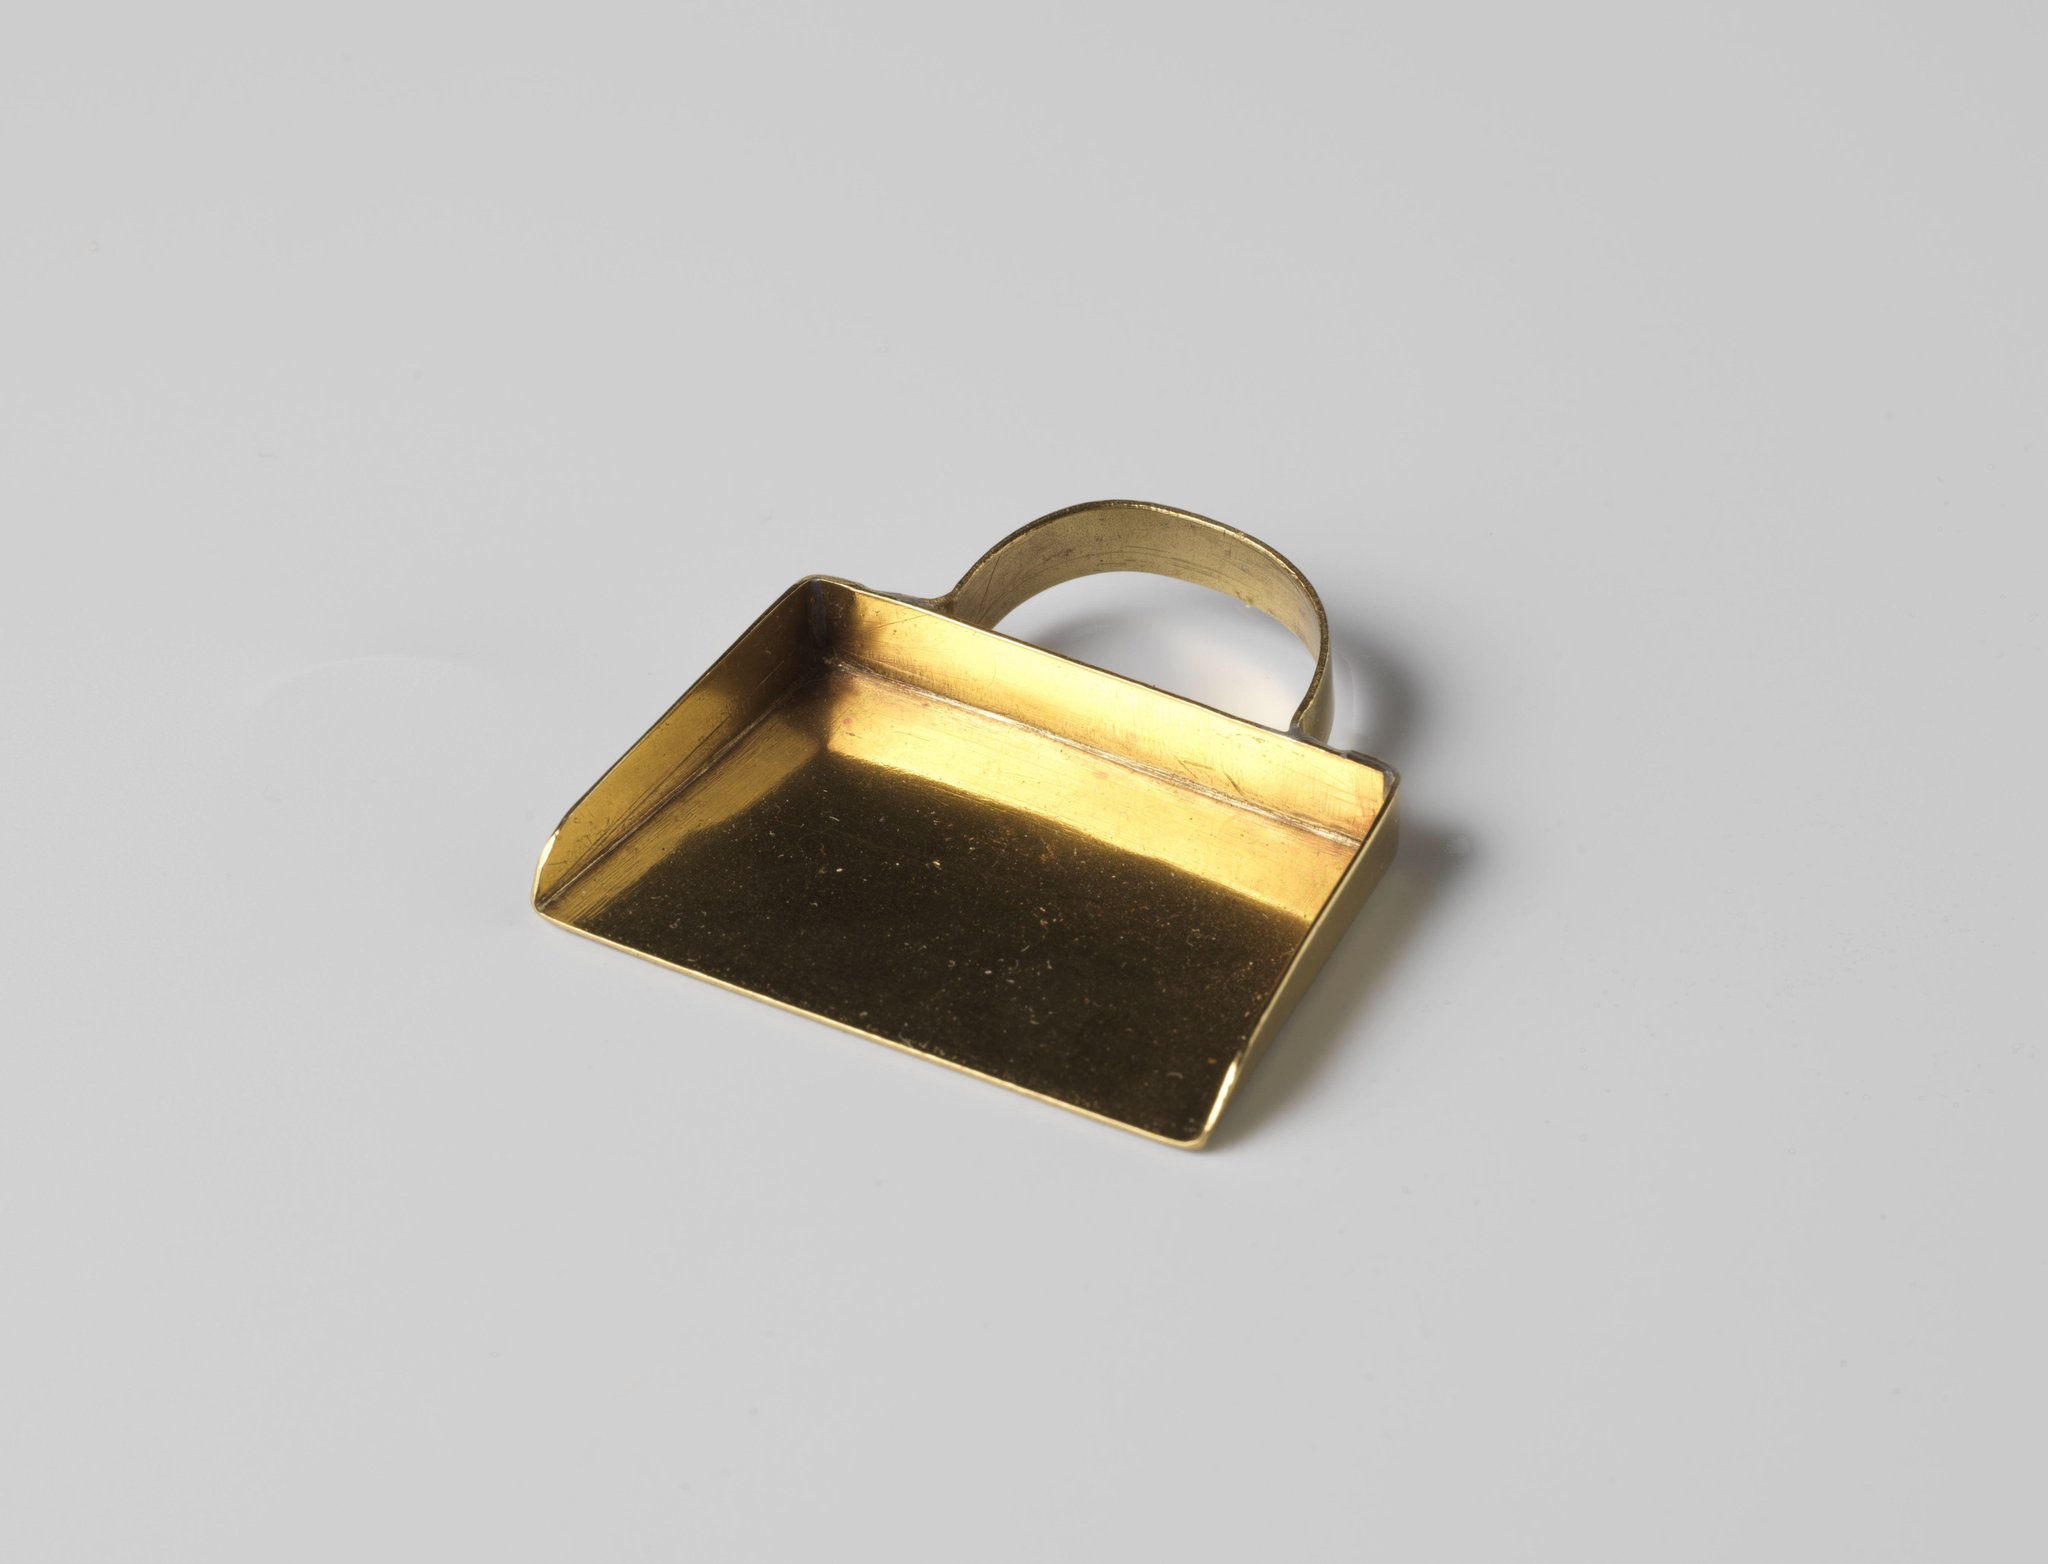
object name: miniature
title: Stofblik van geelkoper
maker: Anonymous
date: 1700-1799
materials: copper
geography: amsterdam